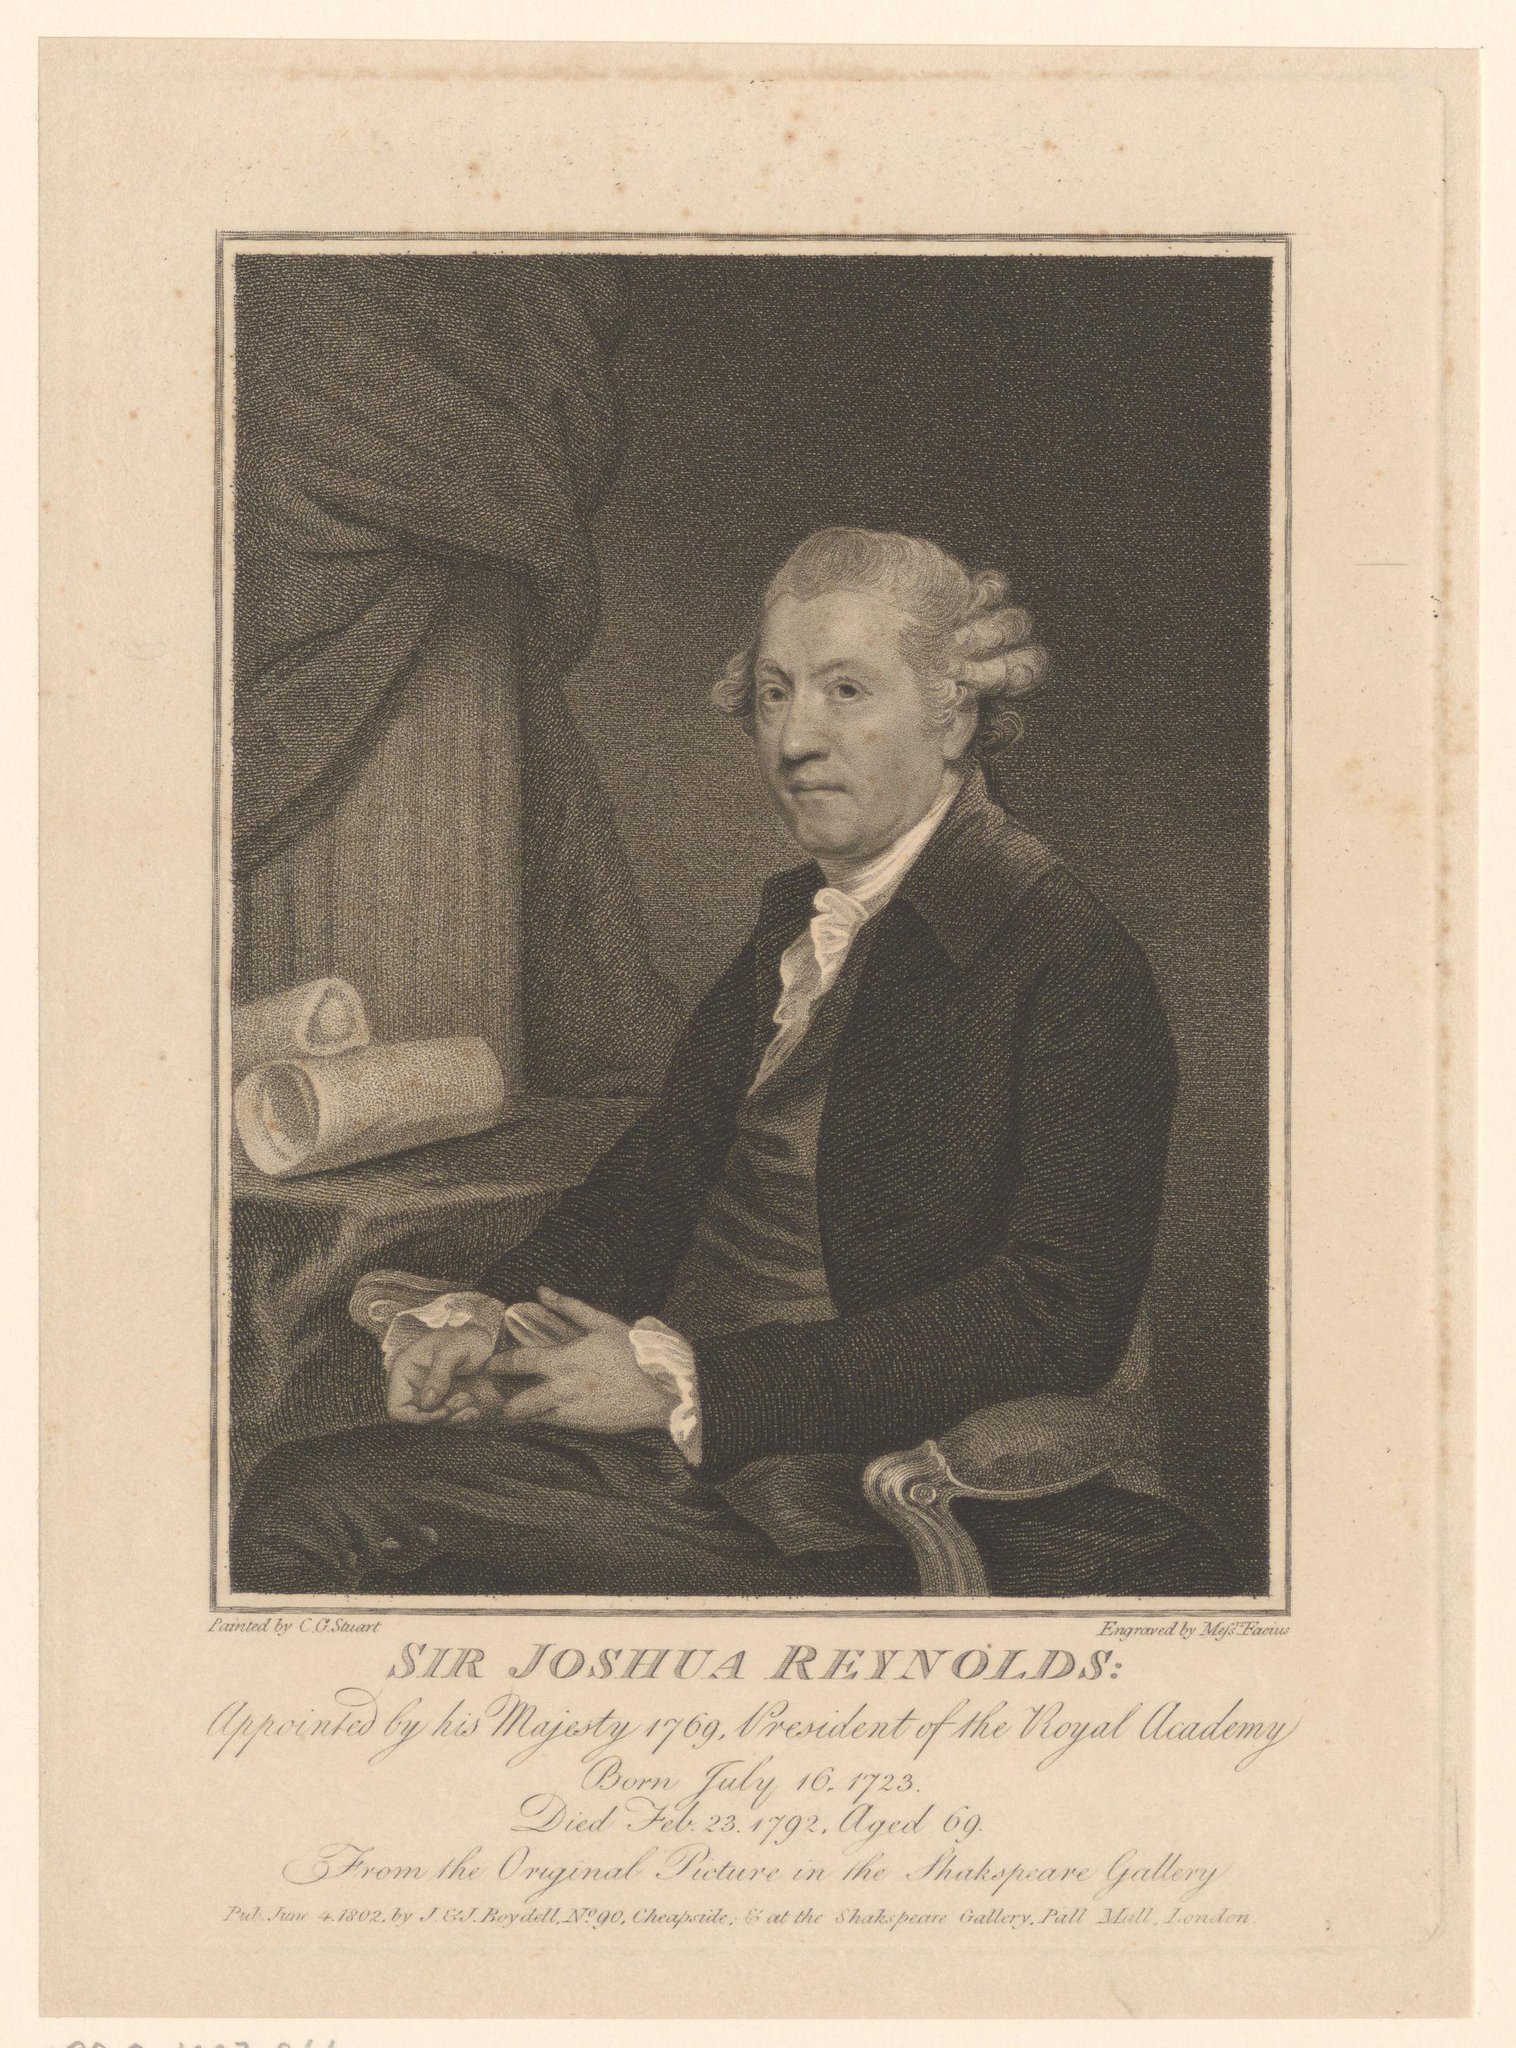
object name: print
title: Sir Joshua Reynolds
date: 1802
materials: paper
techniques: etching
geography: london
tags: london, painter, joshua reynolds, historical persons, portrait, self-portrait of painter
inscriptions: collector's mark: Lugt 2228